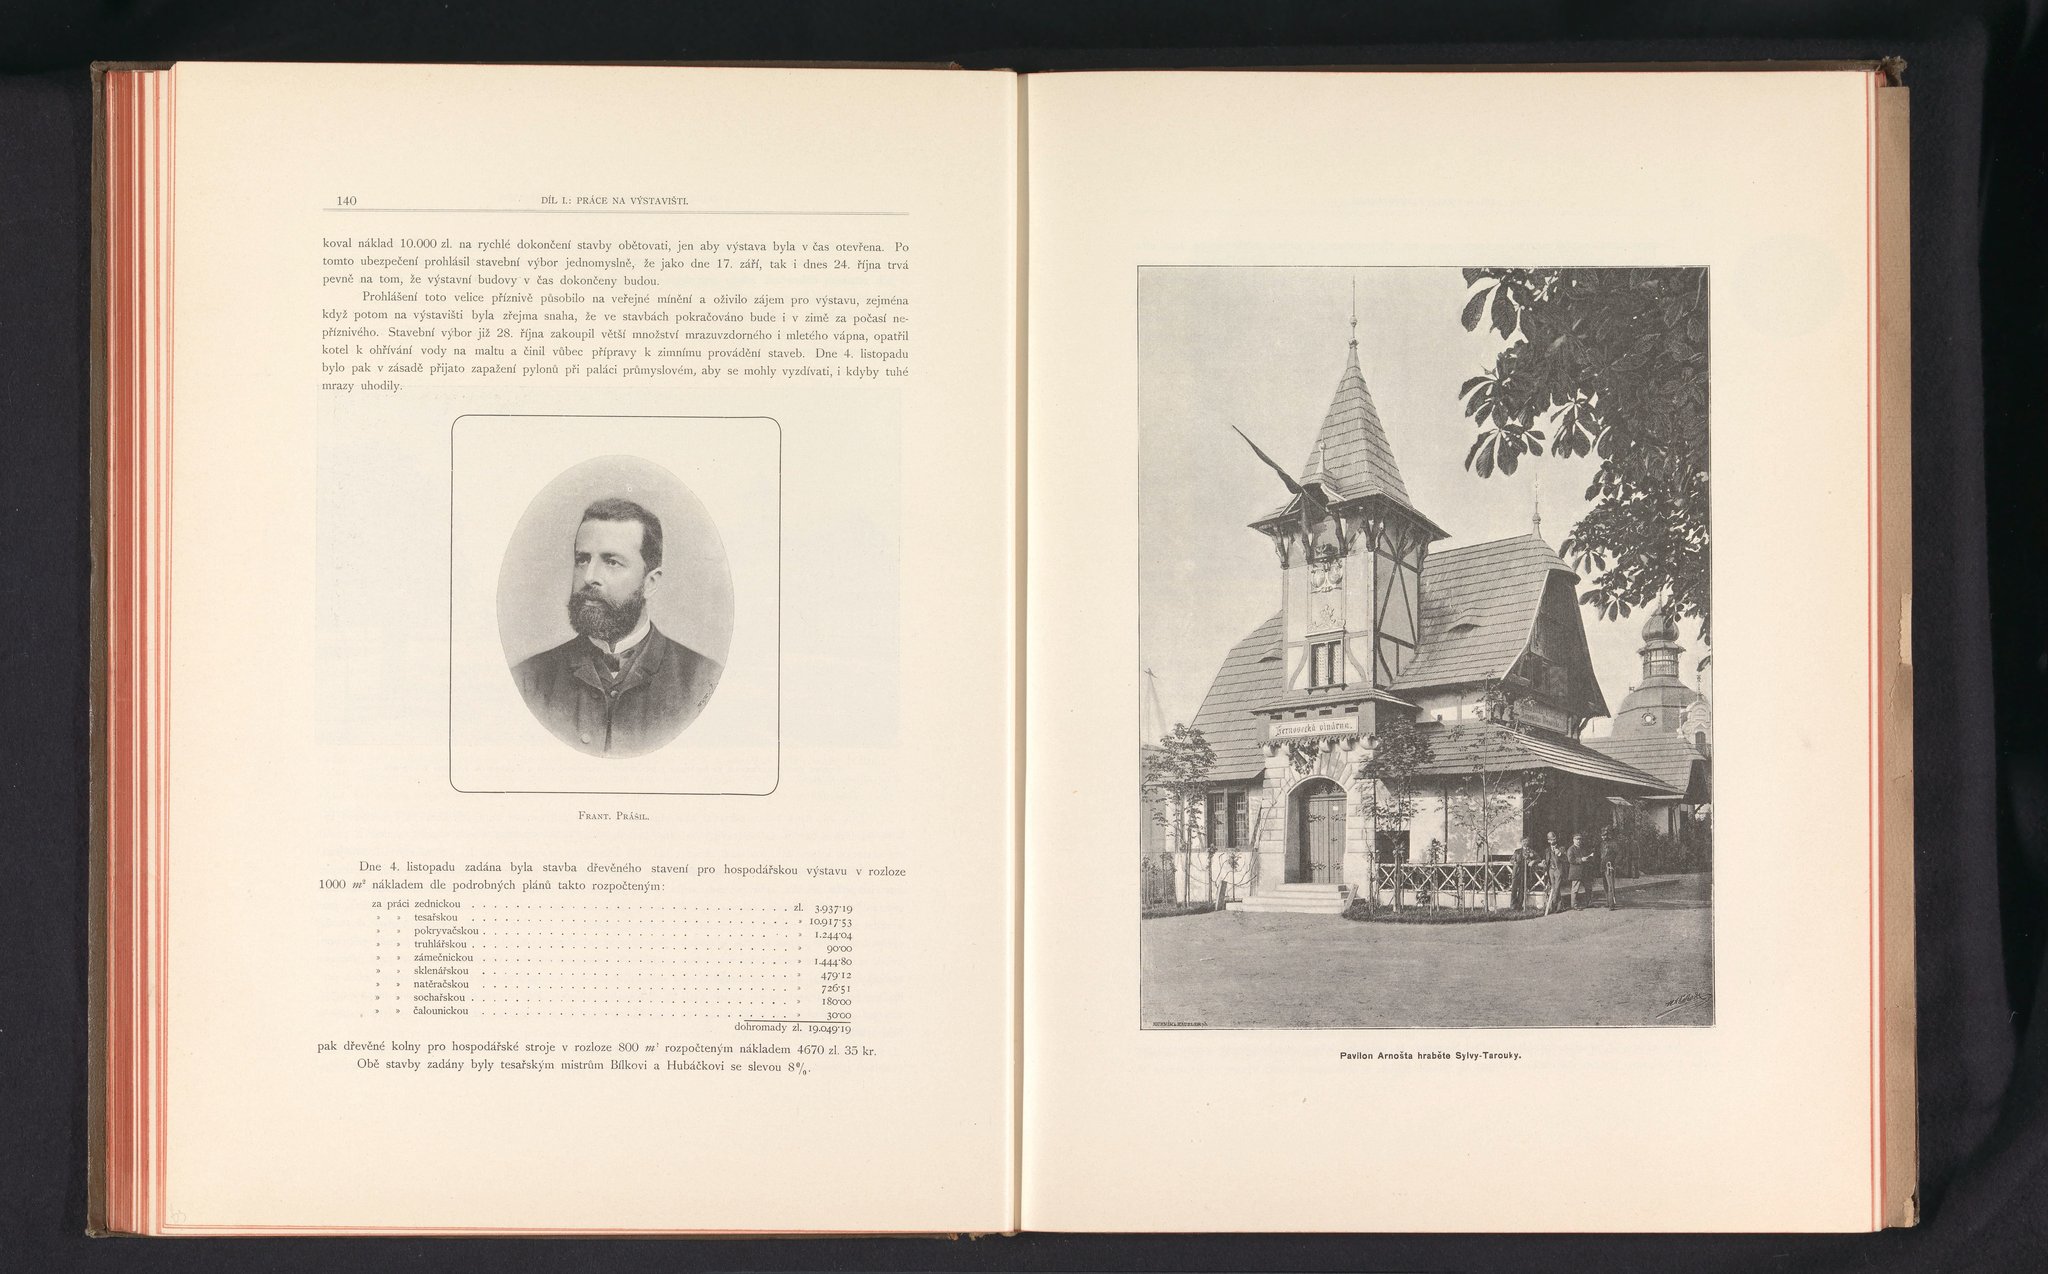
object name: photomechanical print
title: Portret van Frantisek Prásil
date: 1888-1893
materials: paper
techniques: autotype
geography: prague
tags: adult man